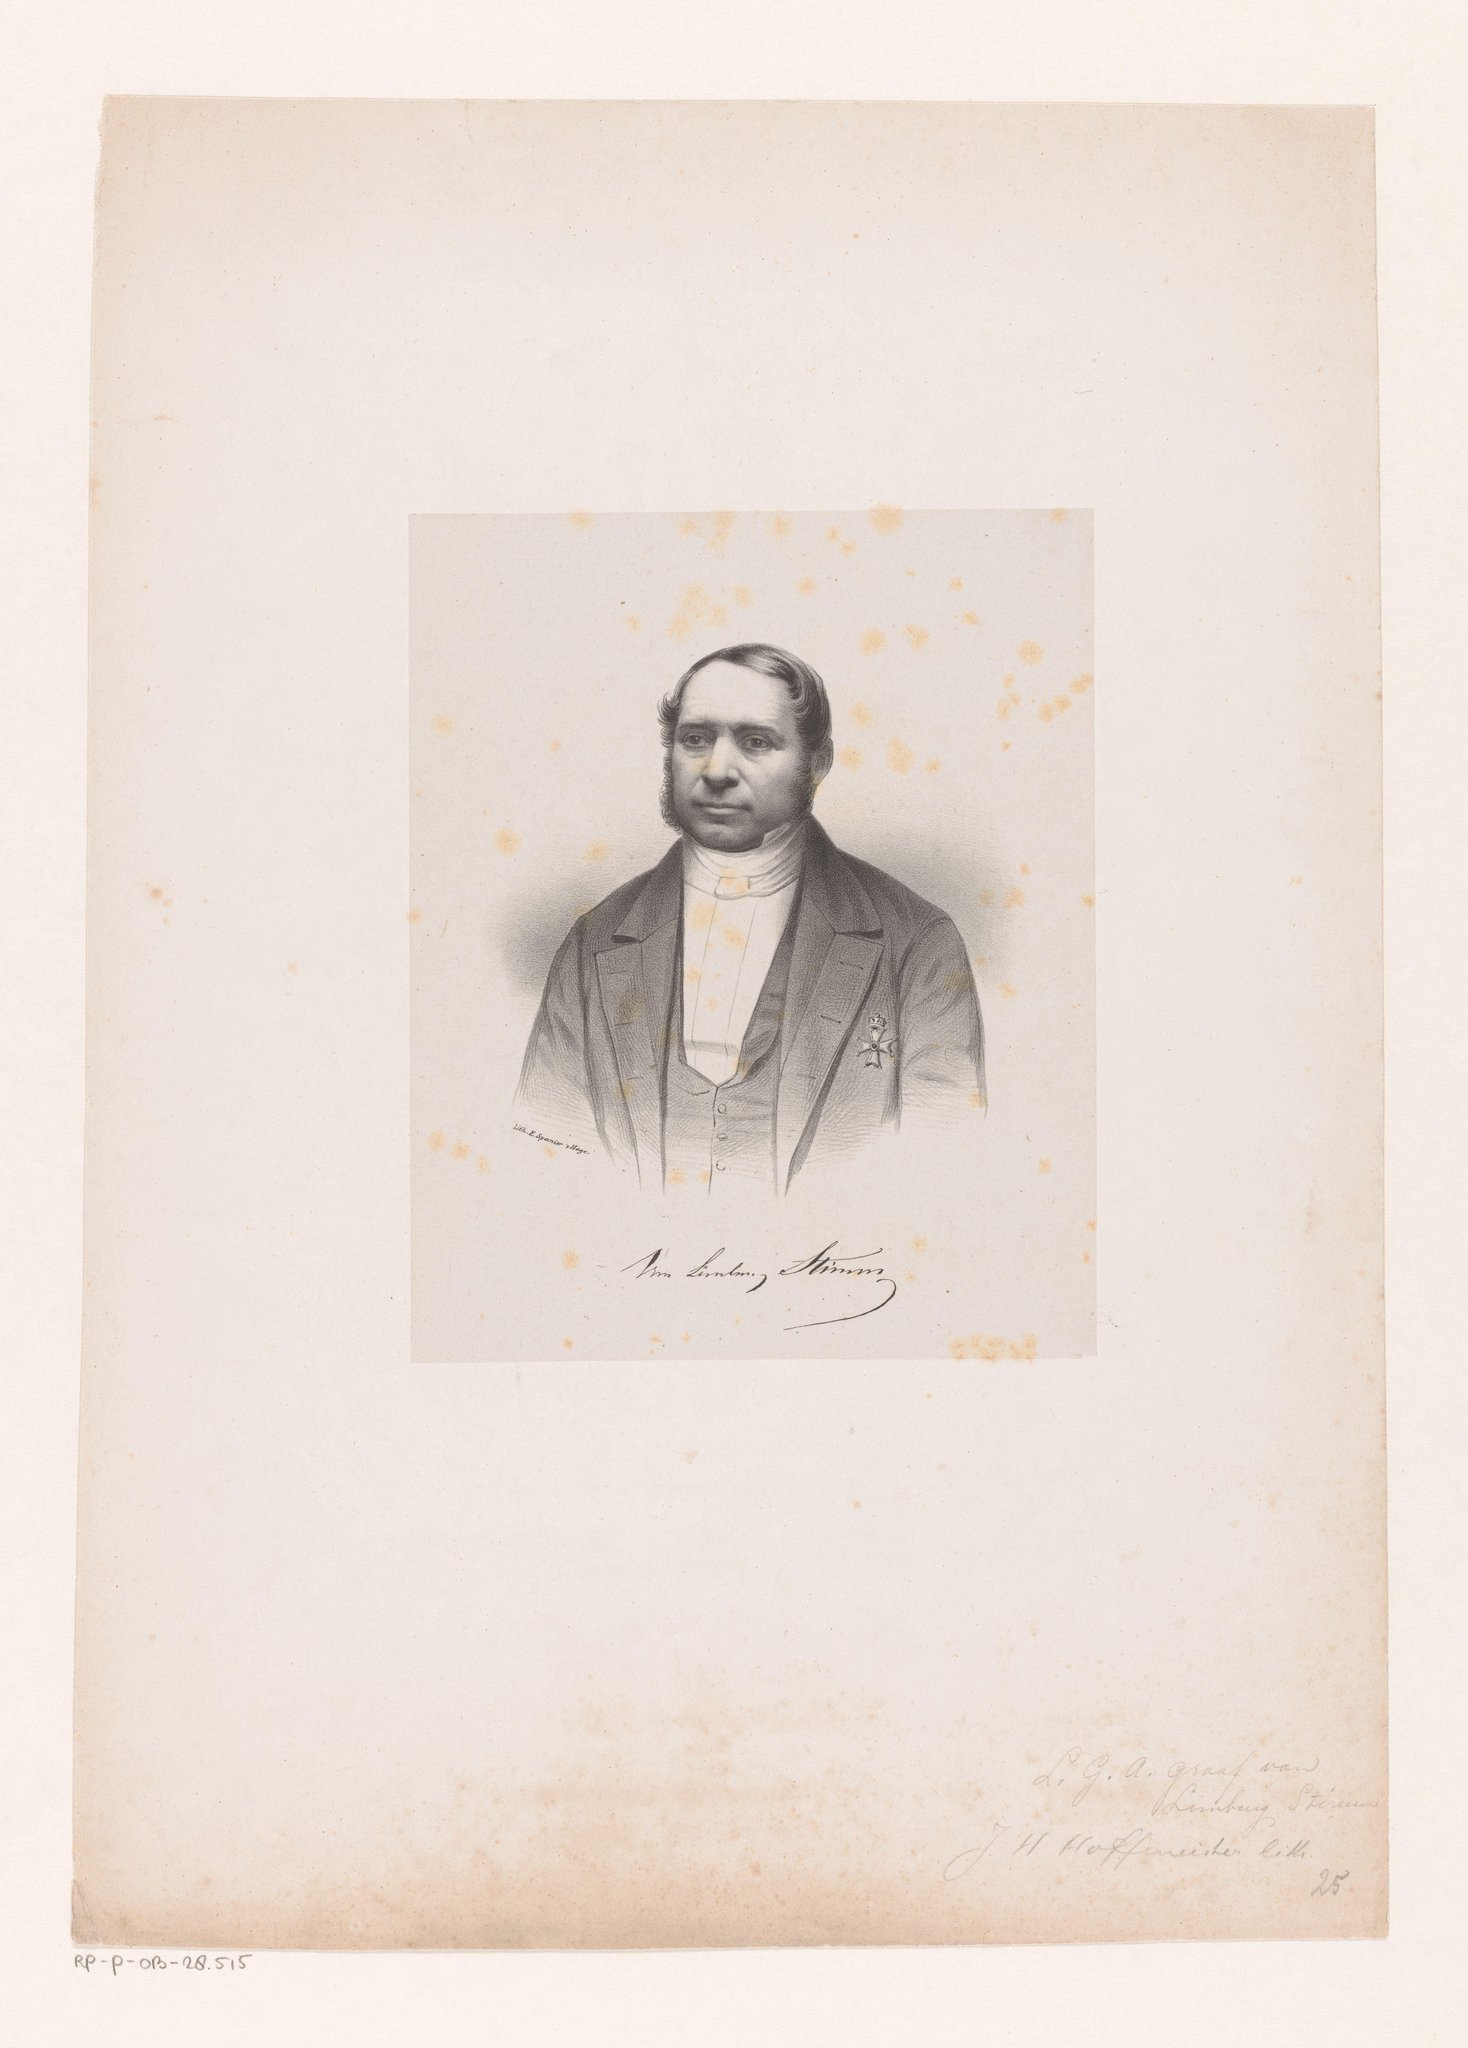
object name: print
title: Portret van Louis Gaspard Adrien van Limburg Stirum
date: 1843-1891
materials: paper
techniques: lithograph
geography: netherlands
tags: arnhem, politician, knighthood order, historical persons (+ (full) bust portrait)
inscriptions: collector's mark: Lugt 2228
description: Onder het portret de signatuur van de geportretteerde.